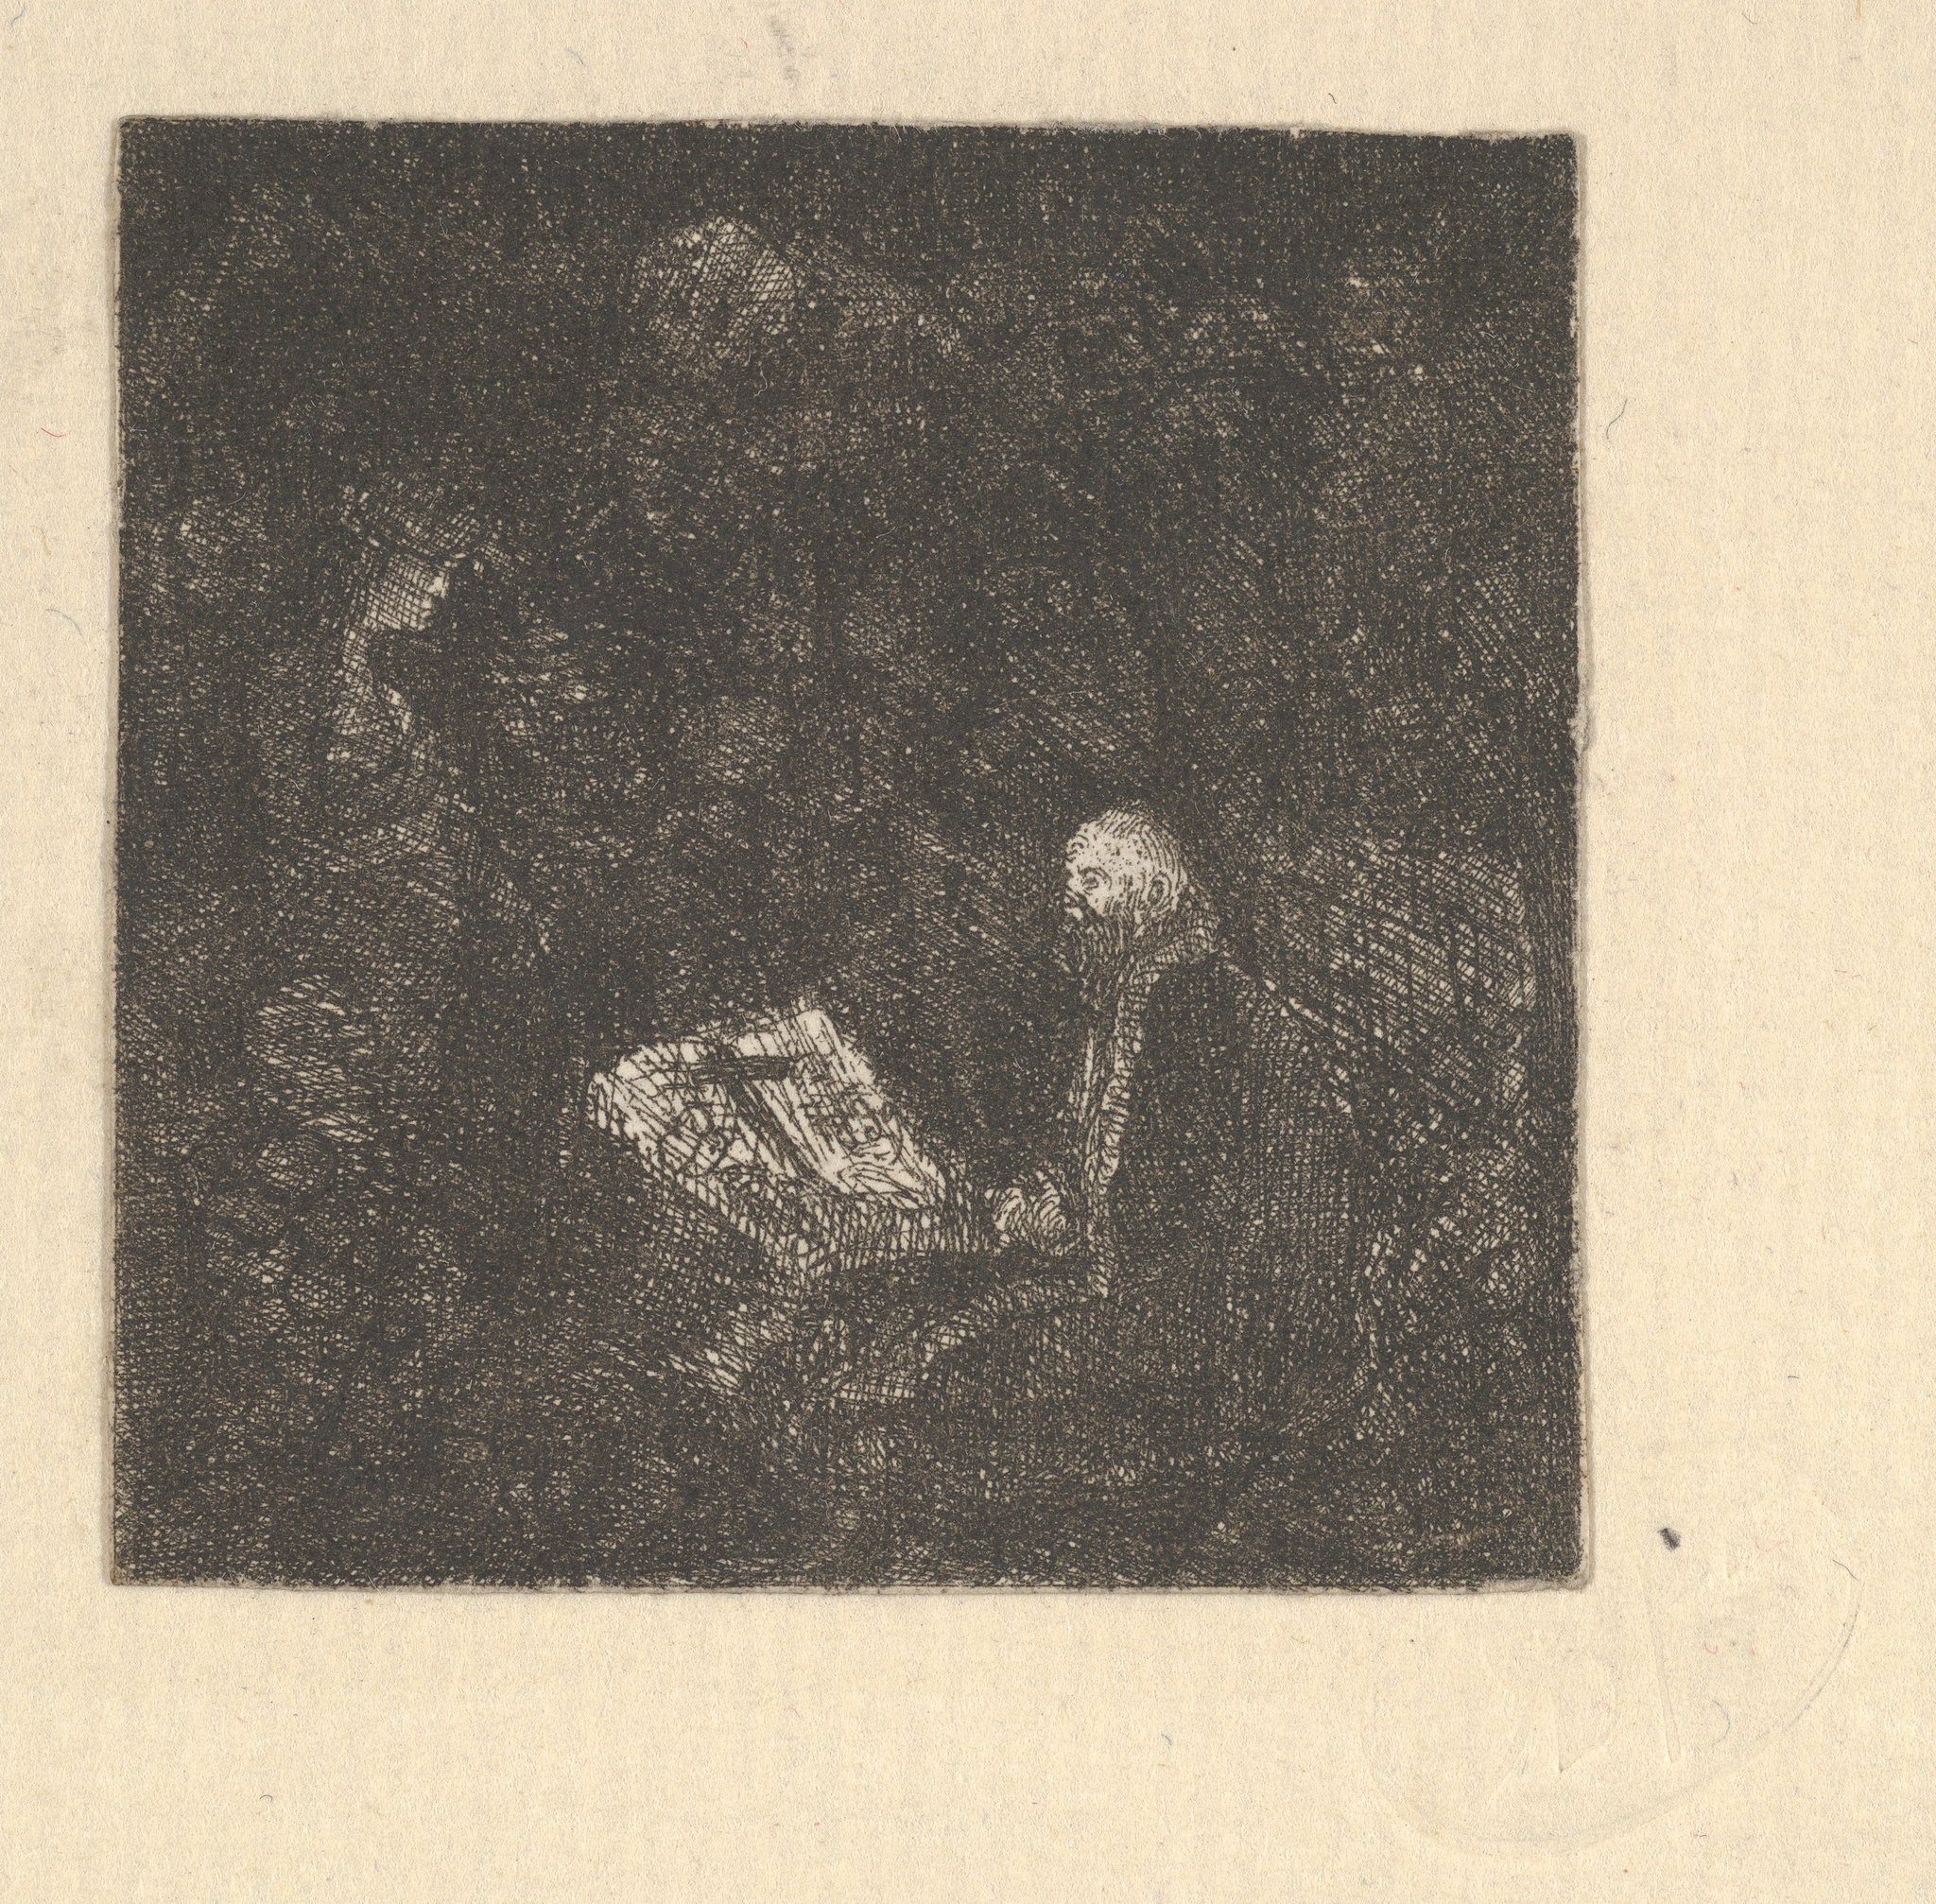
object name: print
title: Saint en Prière (Saint in Prayer)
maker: rodolphe bresdin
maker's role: artist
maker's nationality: french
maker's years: 1822-1885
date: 1839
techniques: etching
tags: men,saints